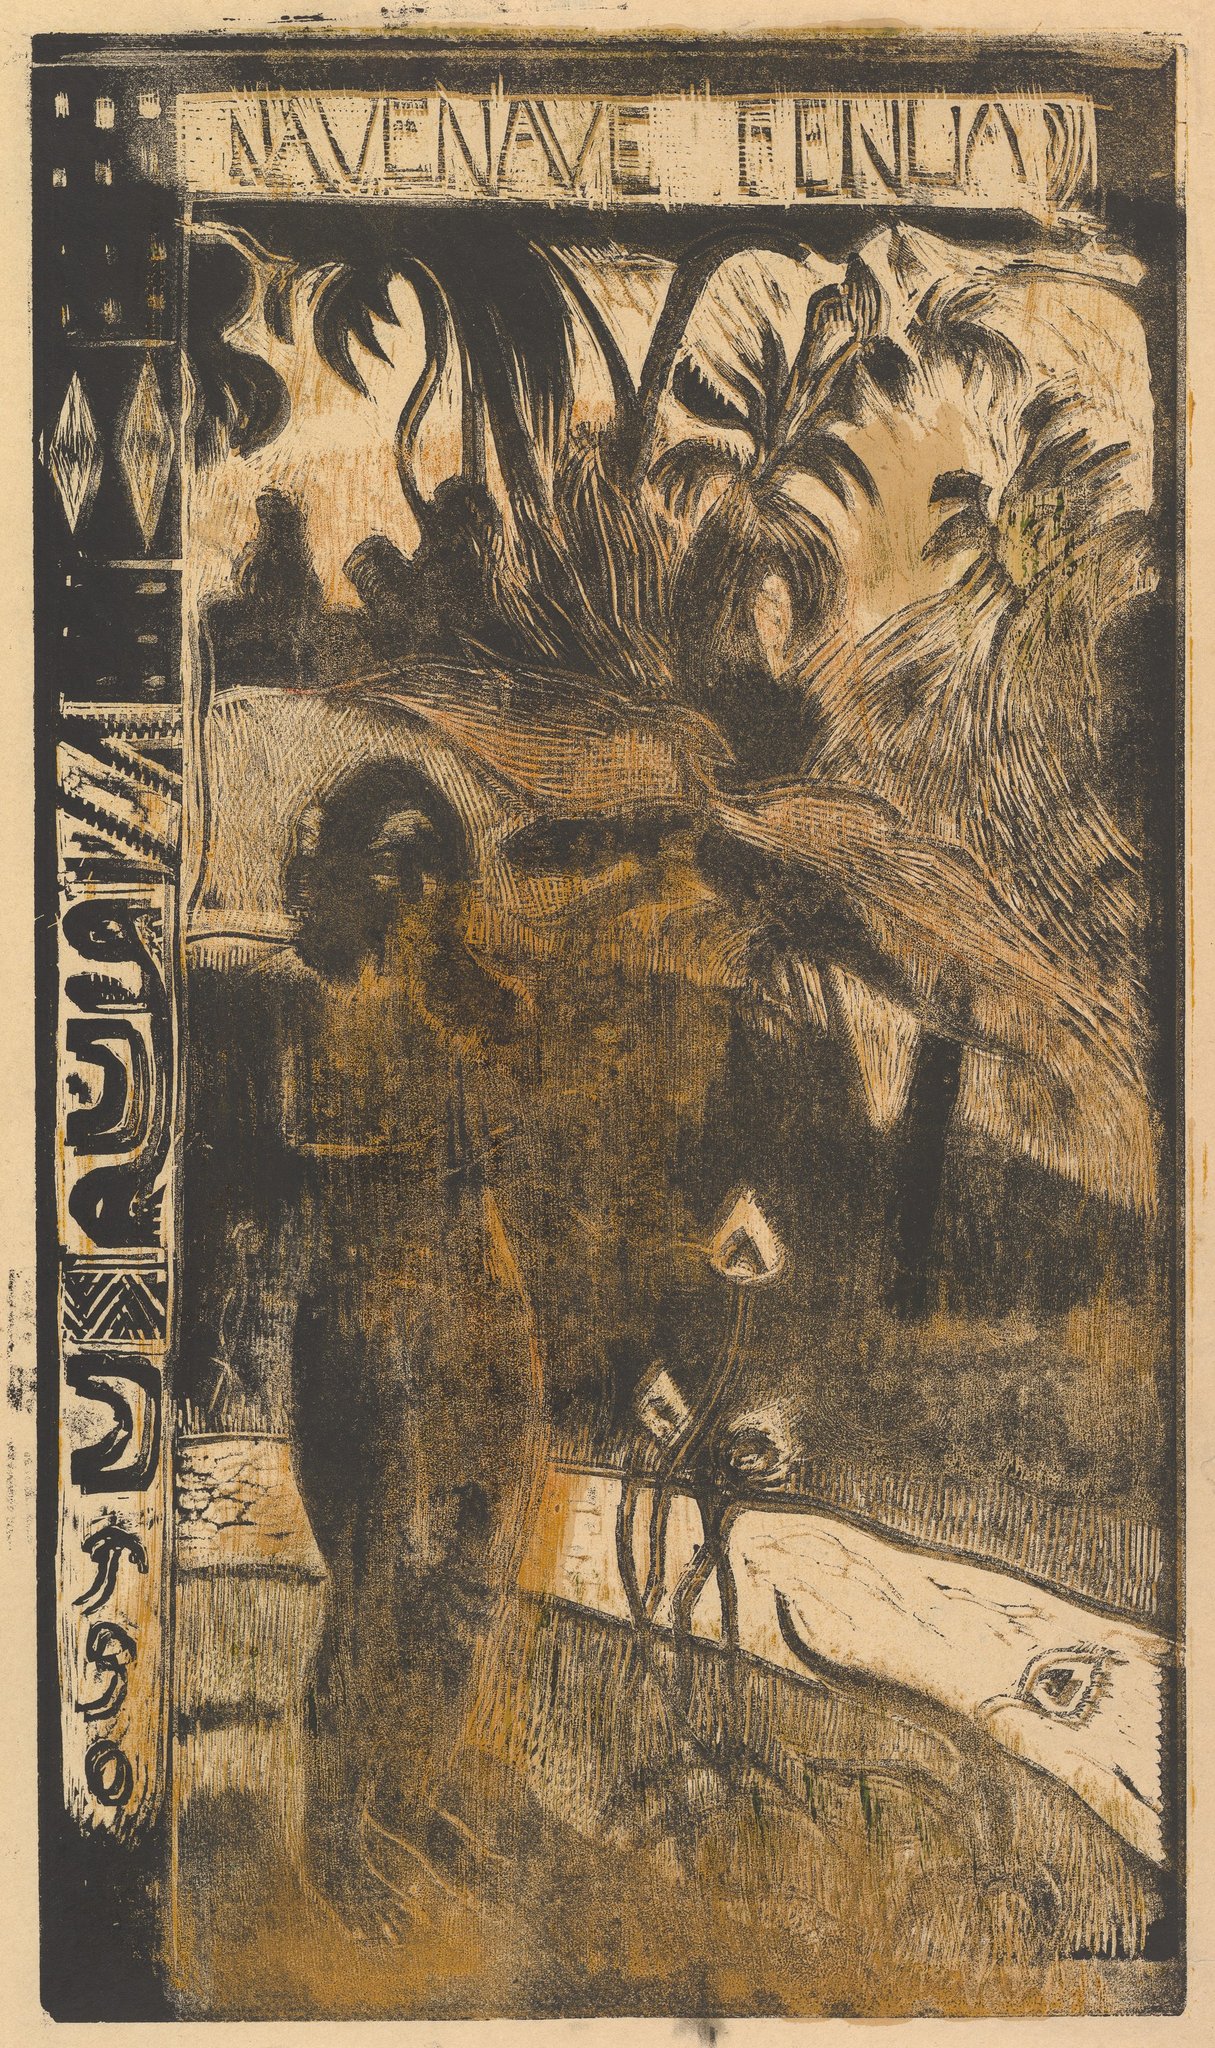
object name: print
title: Delightful Land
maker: paul gauguin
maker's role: artist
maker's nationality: french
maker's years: 1848-1903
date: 1893-1894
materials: paper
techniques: printing, woodcut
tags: women